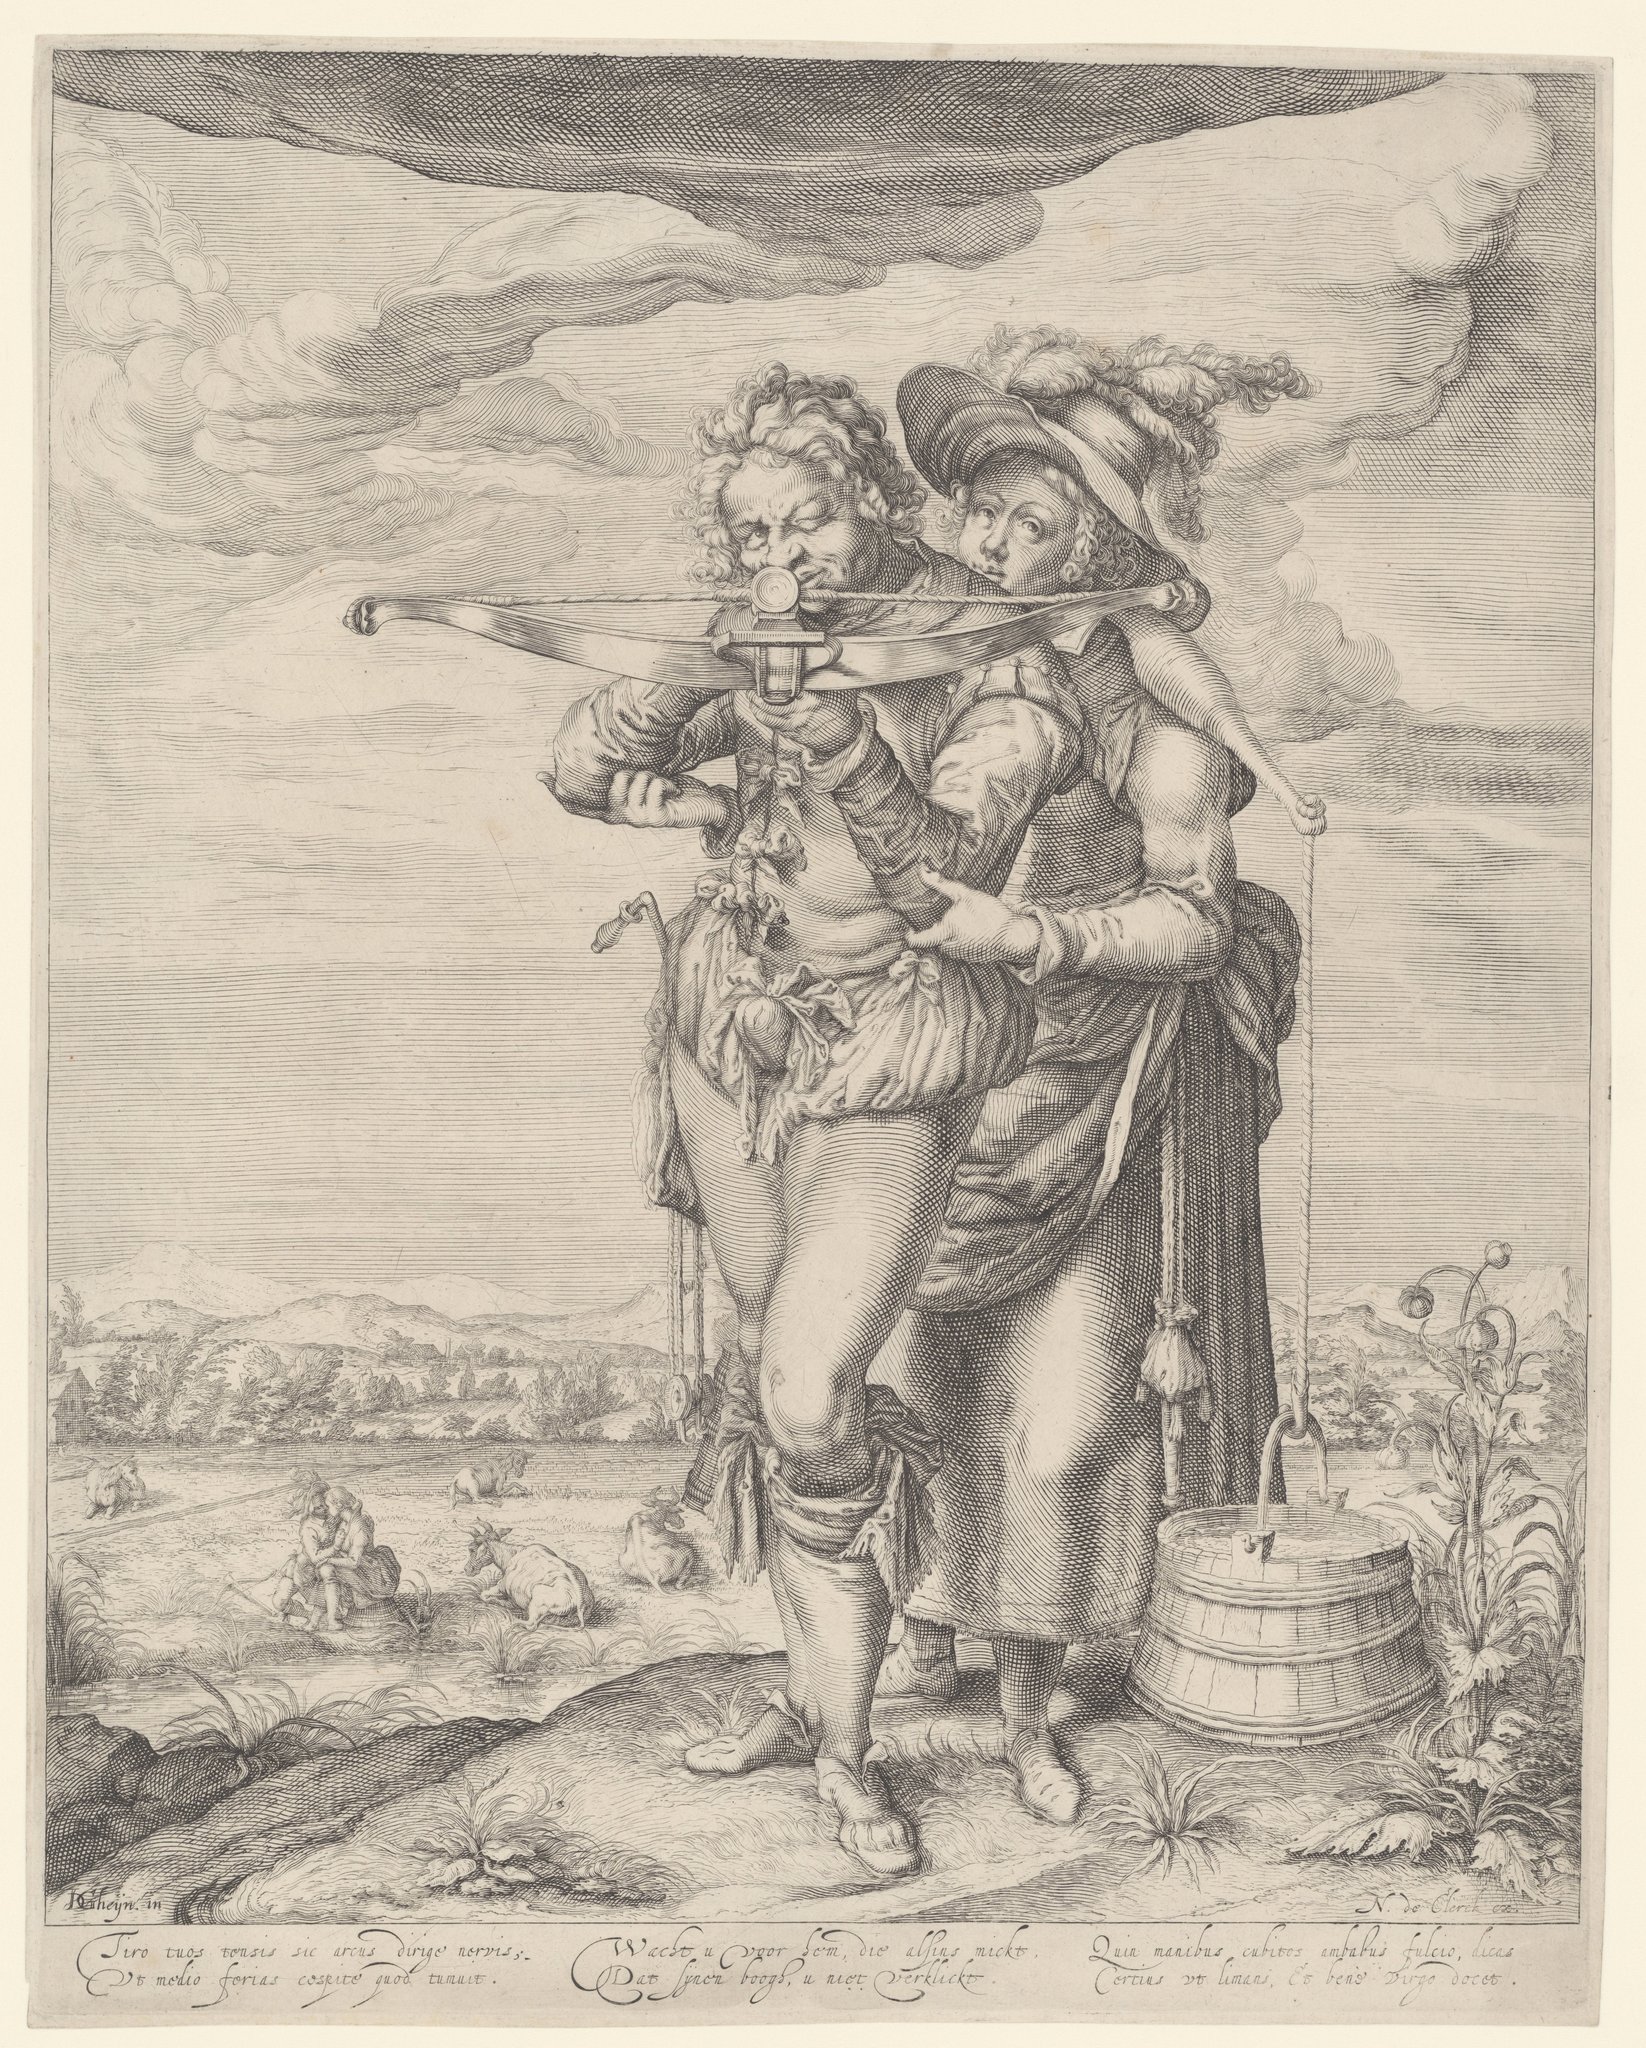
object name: print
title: Boogschutter en melkmeisje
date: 1608-1612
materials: paper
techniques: engraving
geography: netherlands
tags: archer's weapons: bow and arrow, milkmaid, shooting with bow and arrow, archery (~ games of skill)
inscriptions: collector's mark: Lugt 2228a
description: Een melkmeisje houdt de ellebogen van een jongeman vast die met een kruisboog recht op de beschouwer mikt. op de achtergrond een weide waarin het melkmeisje en de boogschutter zitten te vrijen tussen de koeien. Onder de voorstelling een zesregelige tekst: twee regels Latijn, twee regels Nederlands en weer twee regels Latijn.